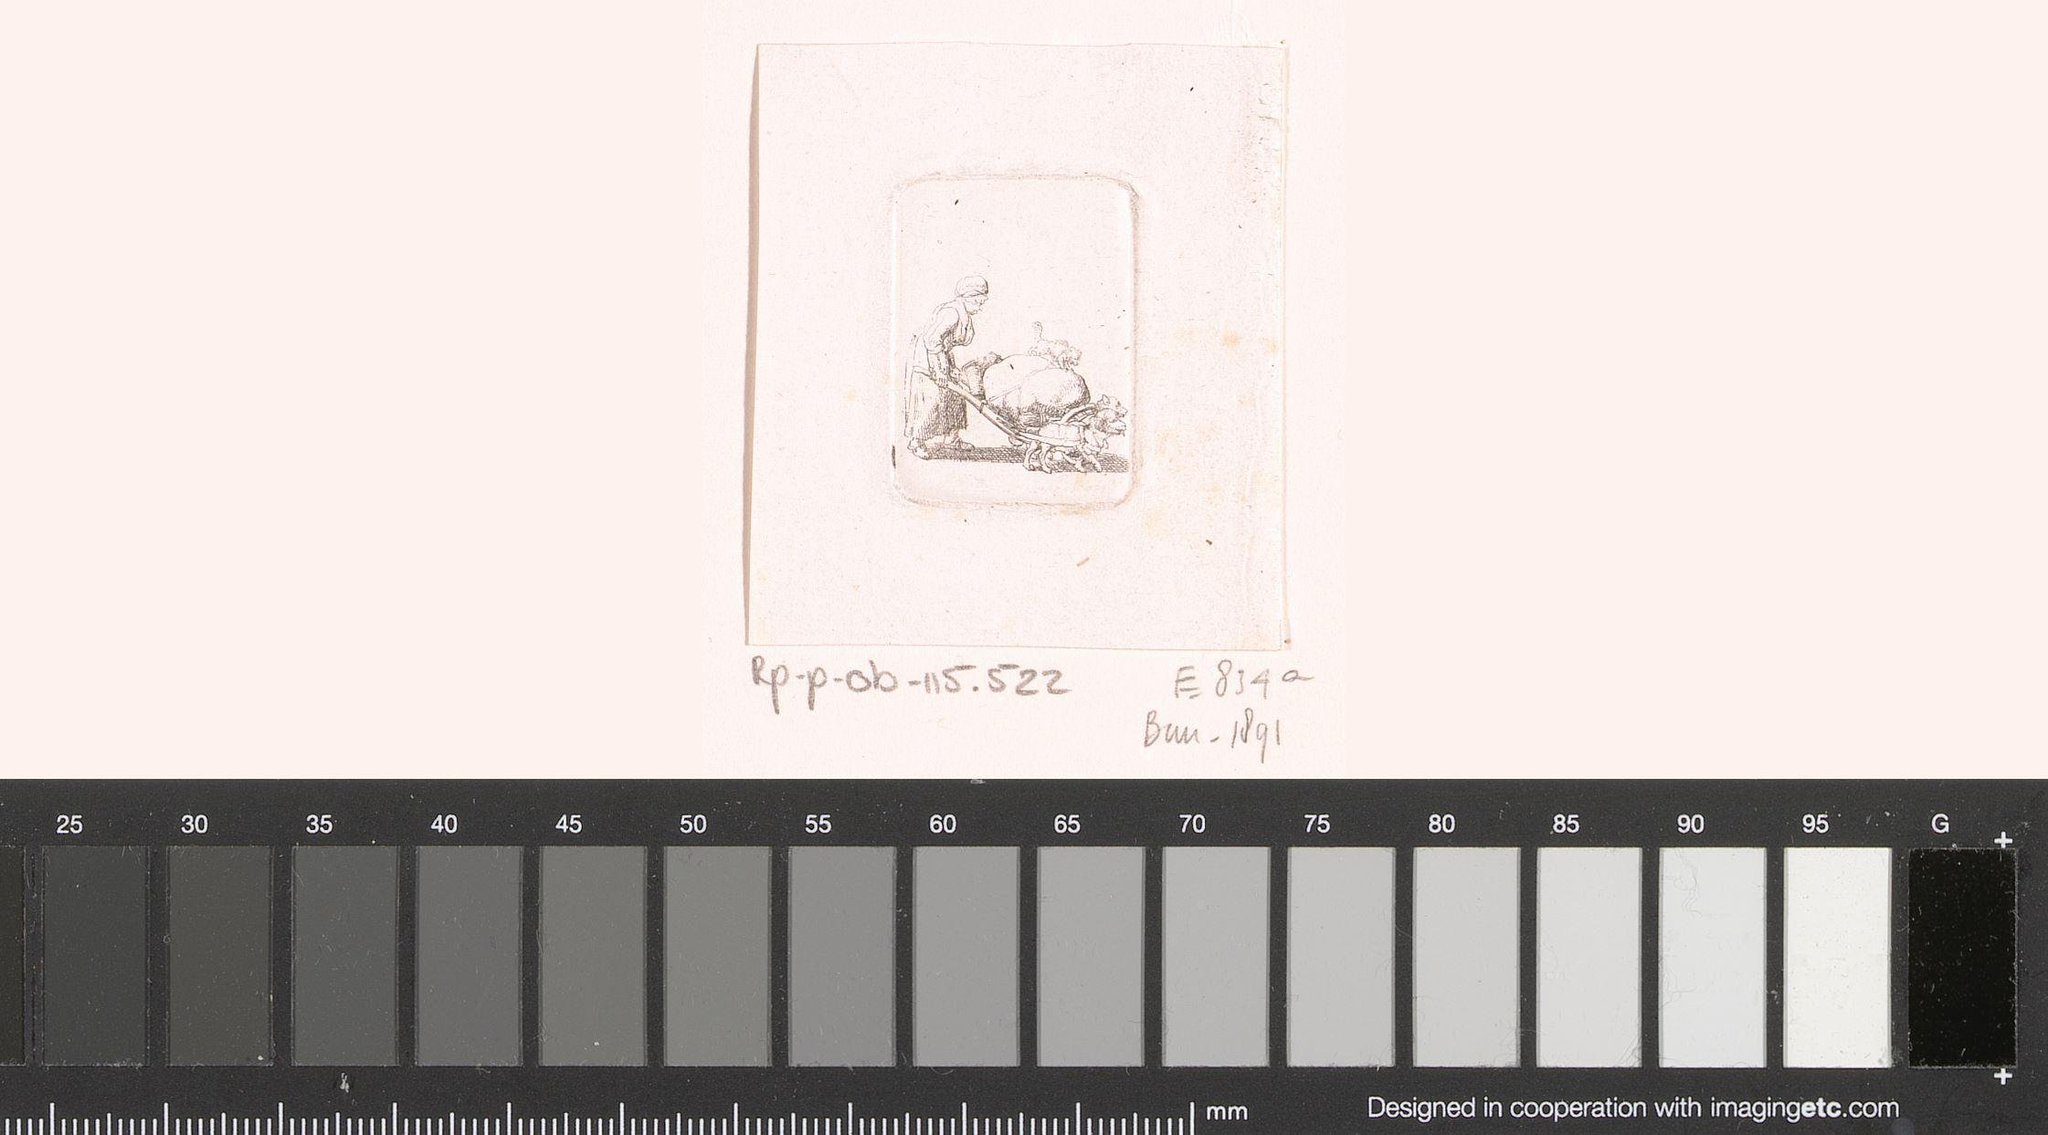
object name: print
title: Vluchtende vrouw achter hondenwagen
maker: daniel nikolaus chodowiecki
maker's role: draughtsman, print maker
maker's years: 1726-1801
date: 1796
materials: paper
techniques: etching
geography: berlin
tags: hand-cart, political refugee, 'émigré'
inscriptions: collector's mark: Lugt 2228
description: Deze prent was, met nog vijf andere schetsmatige marge voorstellingen, onderdeel van de plaat waarop de prent 'Vluchtende mensen komen aan bij Hanau' was geëtst. Later is deze plaat versneden.